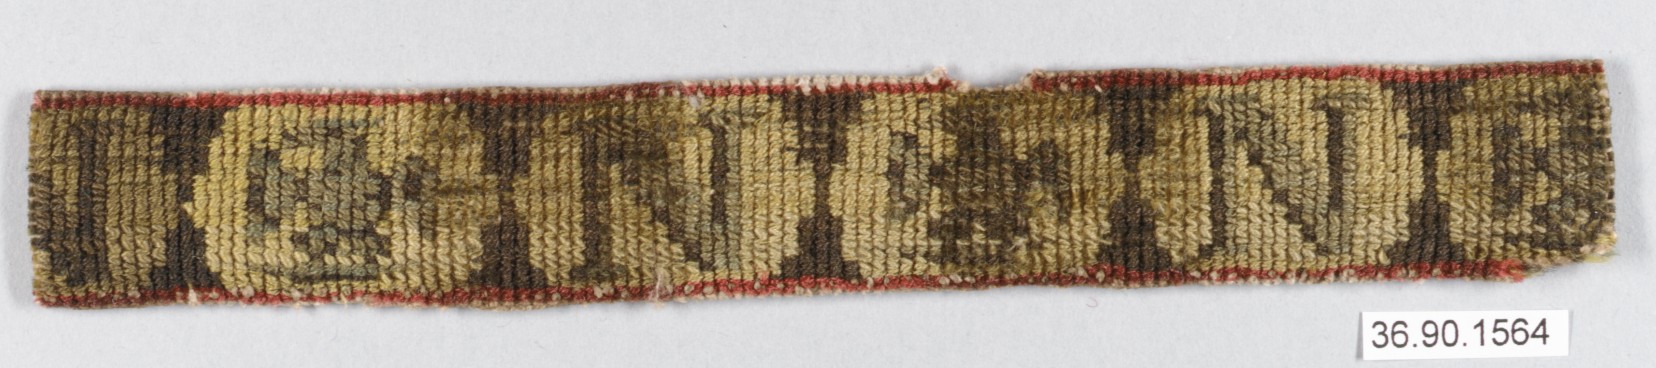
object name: galloon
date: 1801-1900